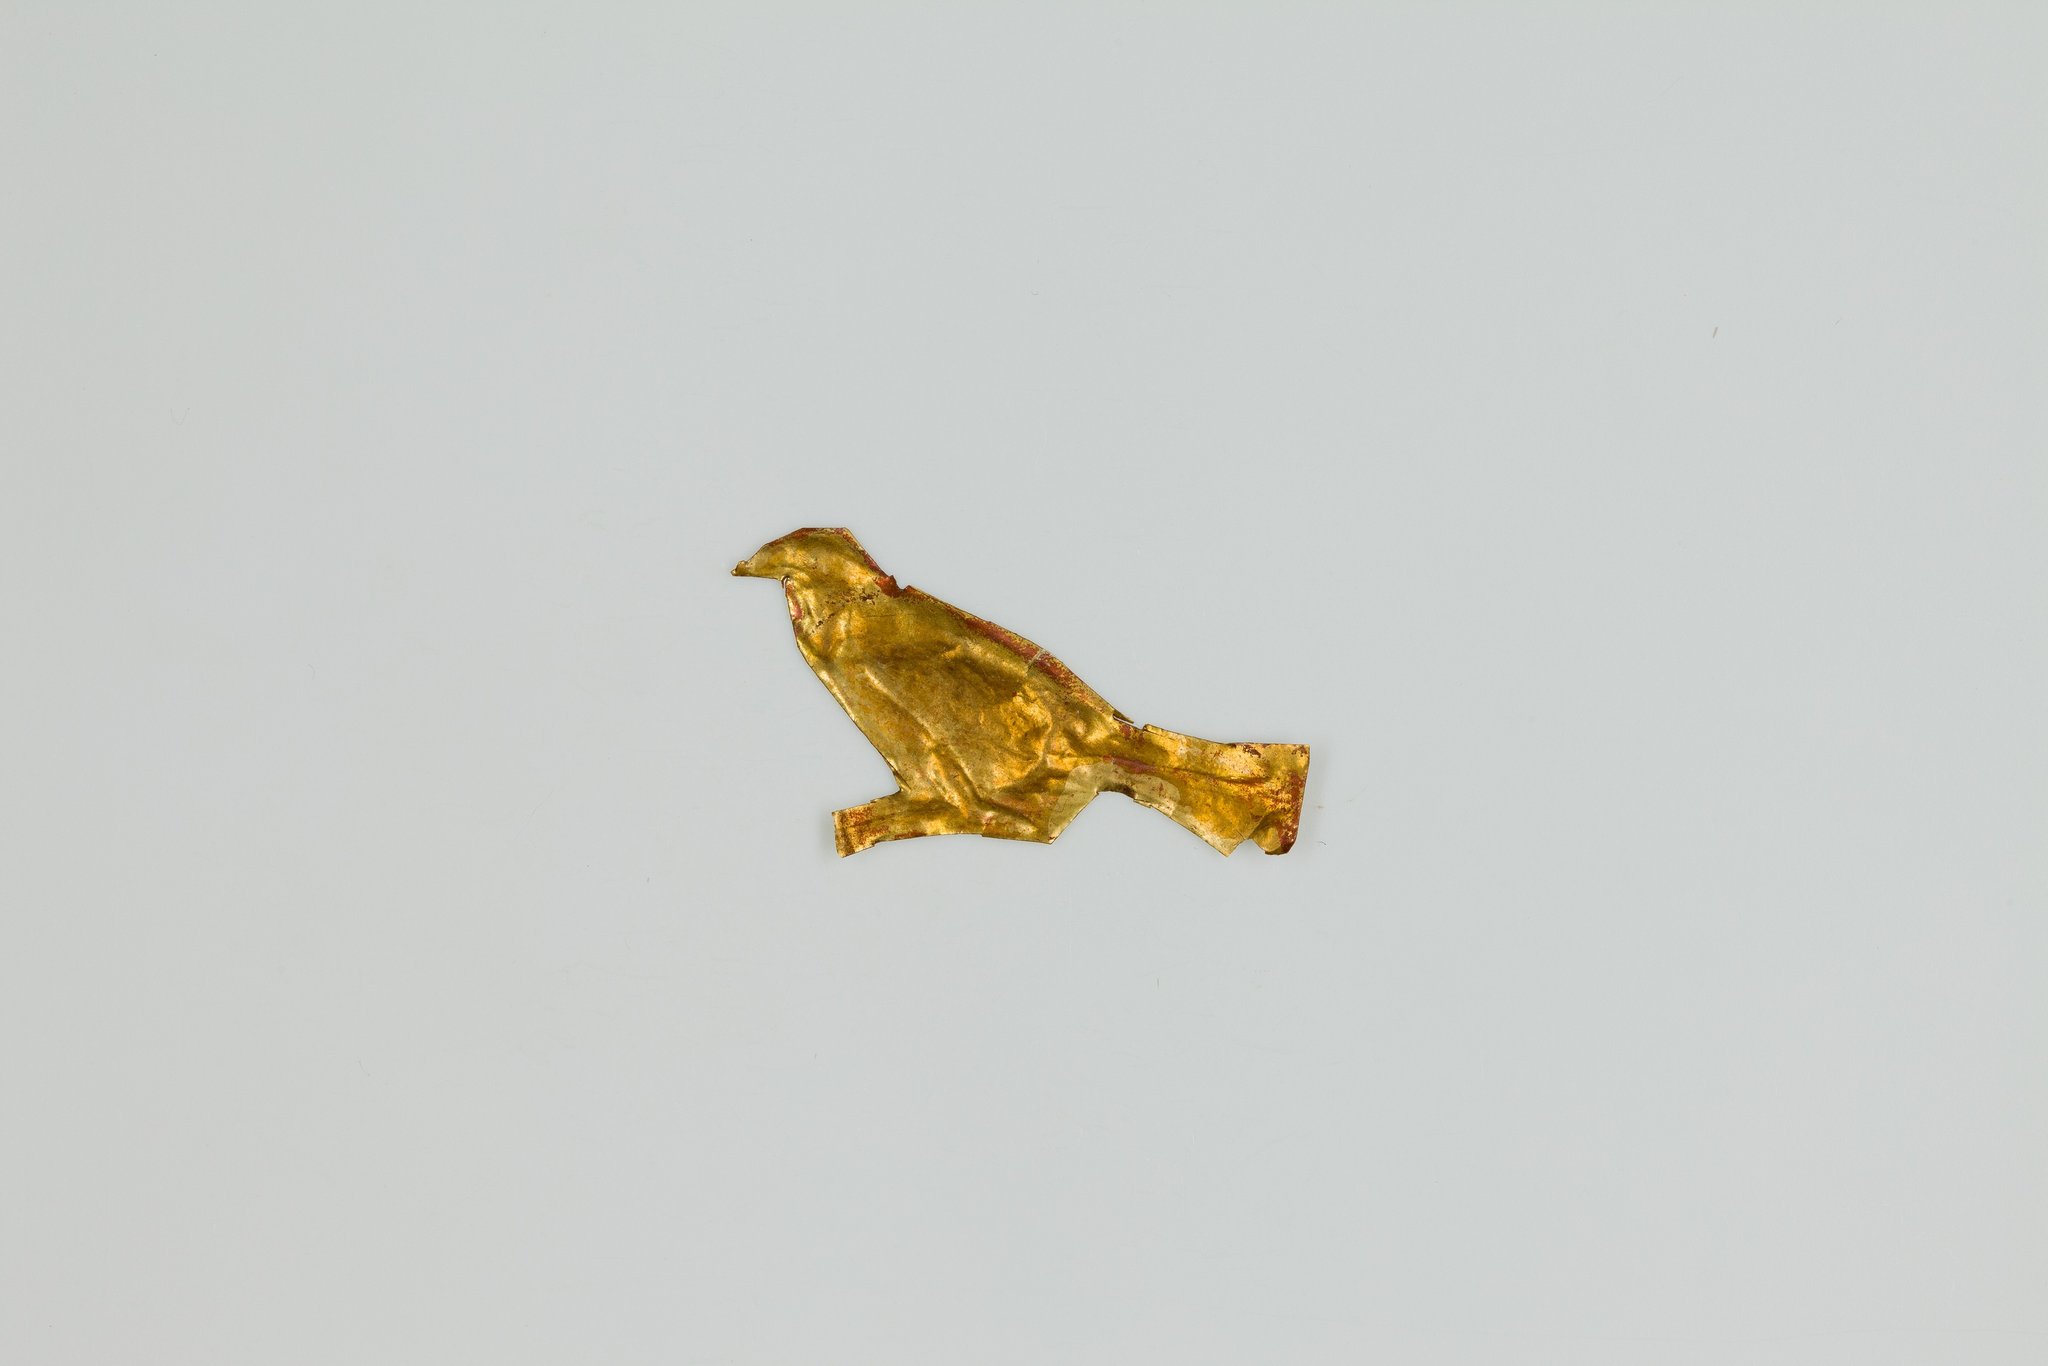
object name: amulet, swallow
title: Swallow amulet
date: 664-380 BCE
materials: gold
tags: birds